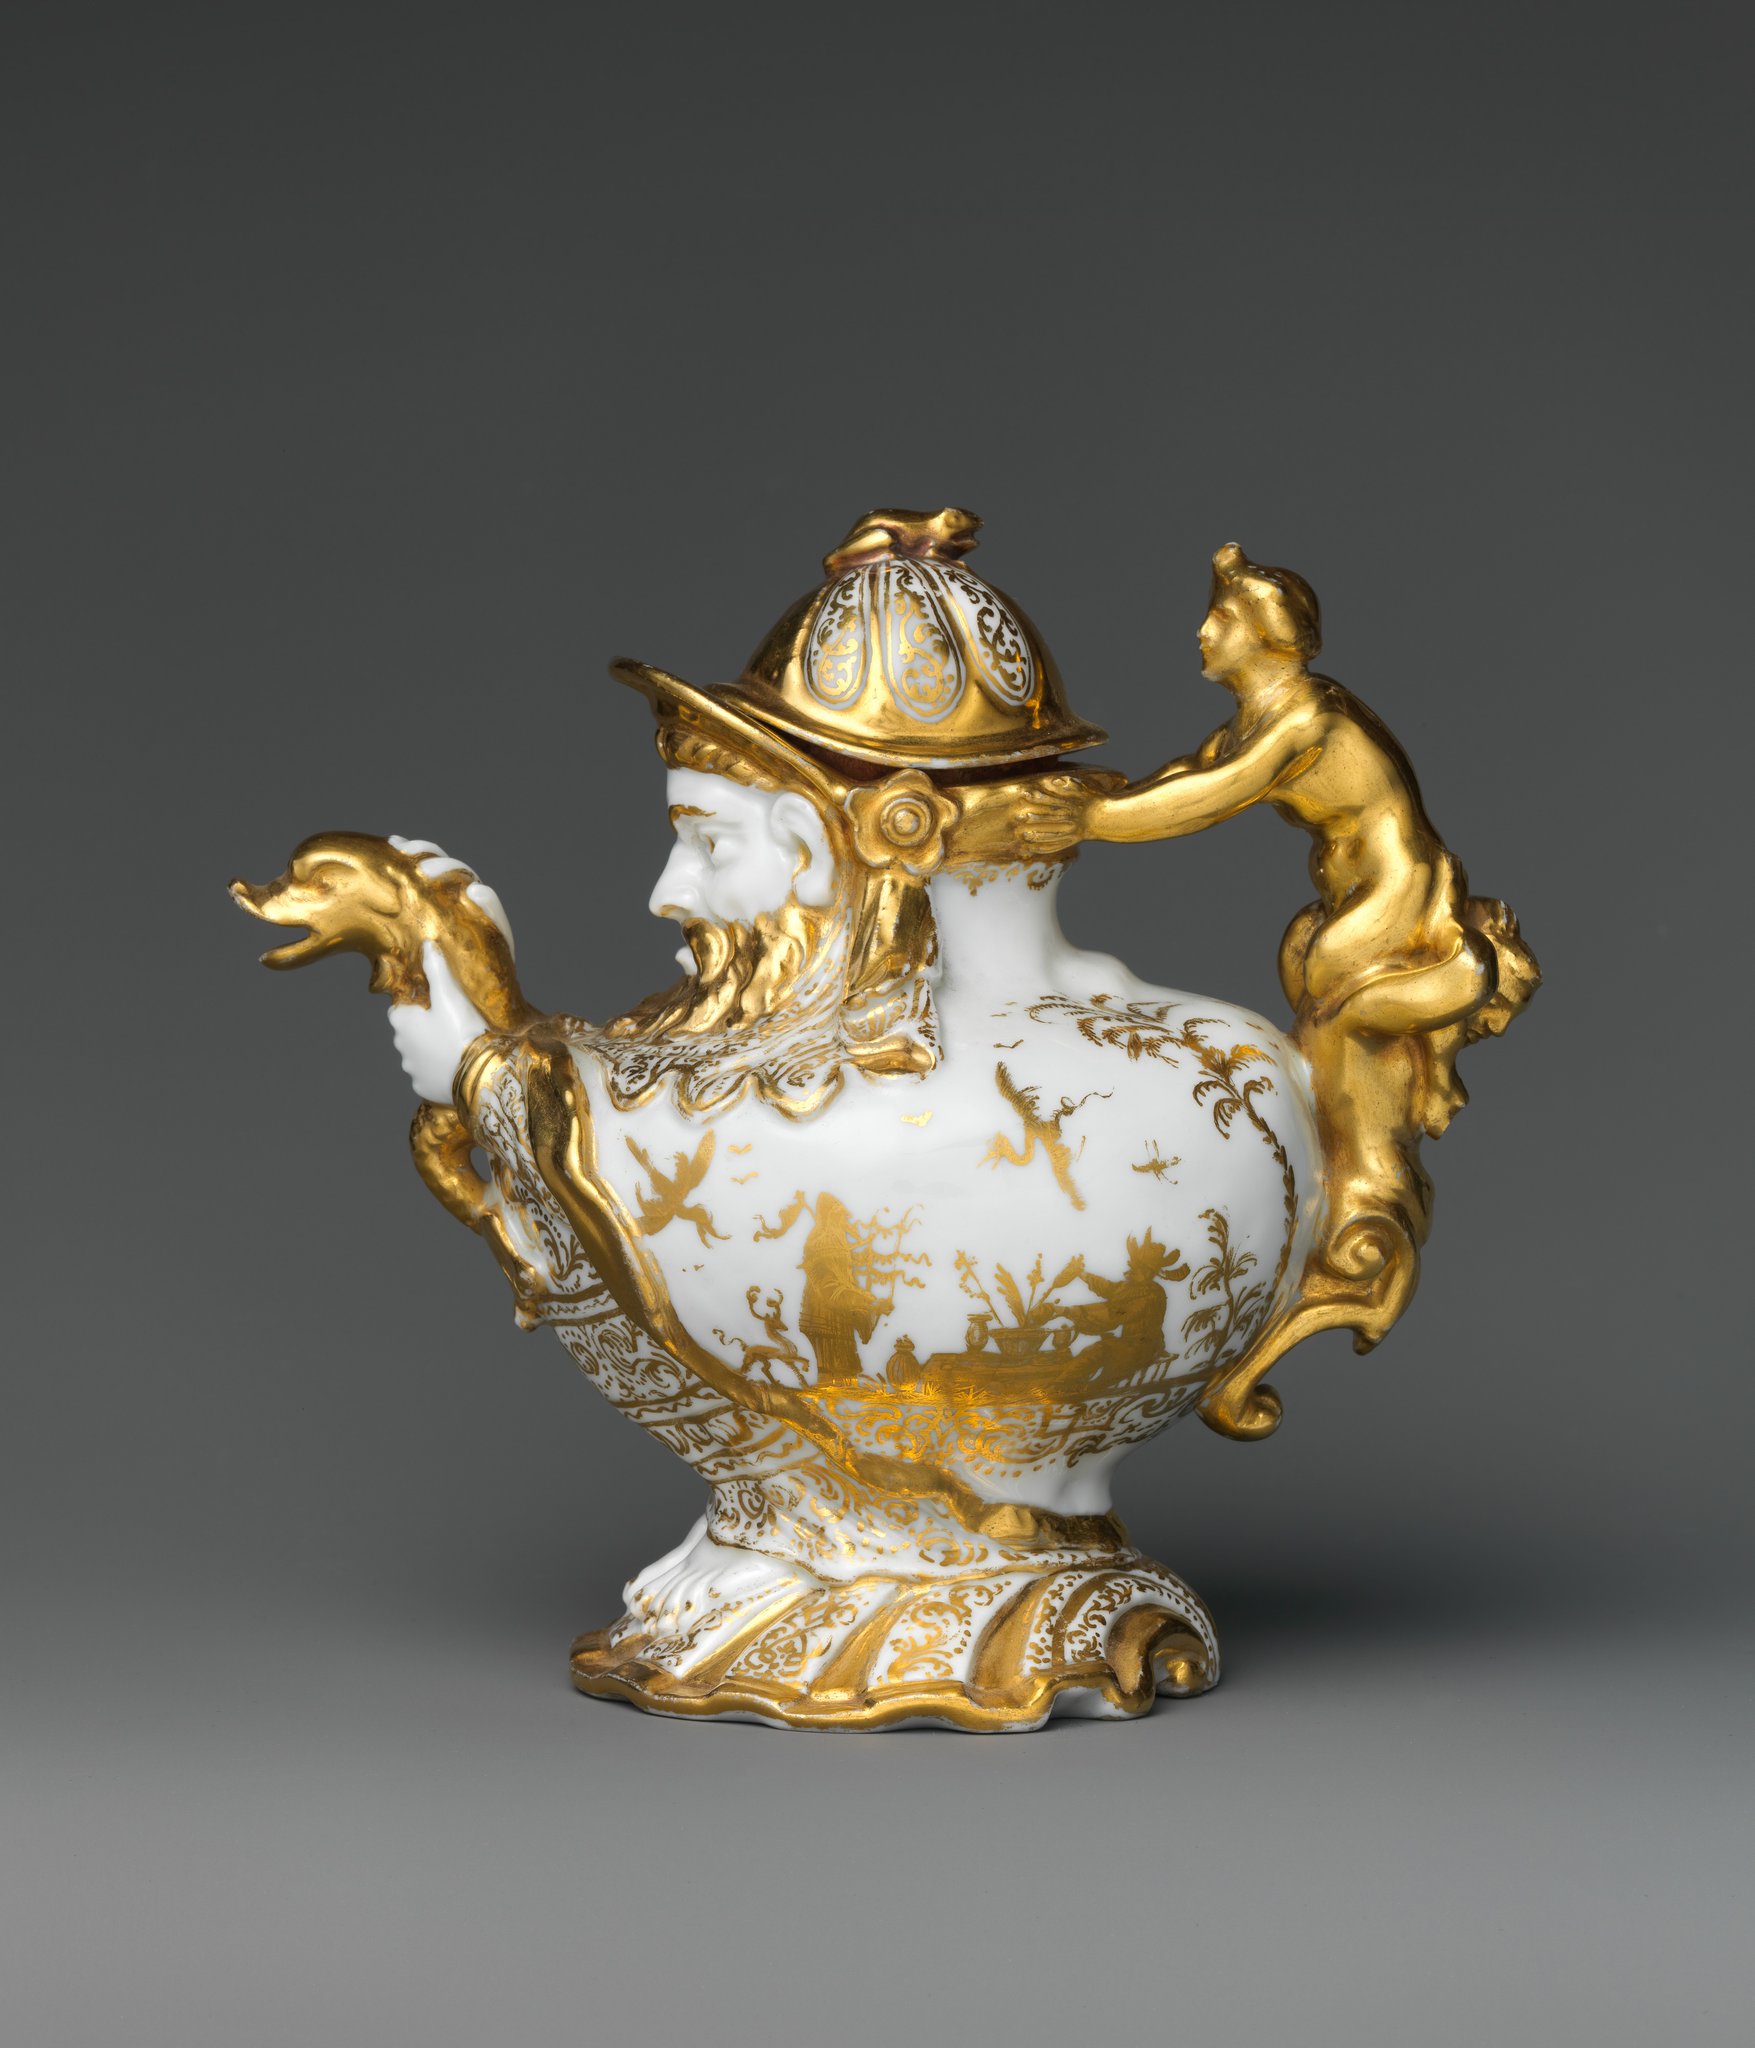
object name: teapot with cover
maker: meissen manufactory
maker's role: manufactory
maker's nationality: german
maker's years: 1710-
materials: hard paste porcelain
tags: birds,chinoiserie,men,dolphins,frogs